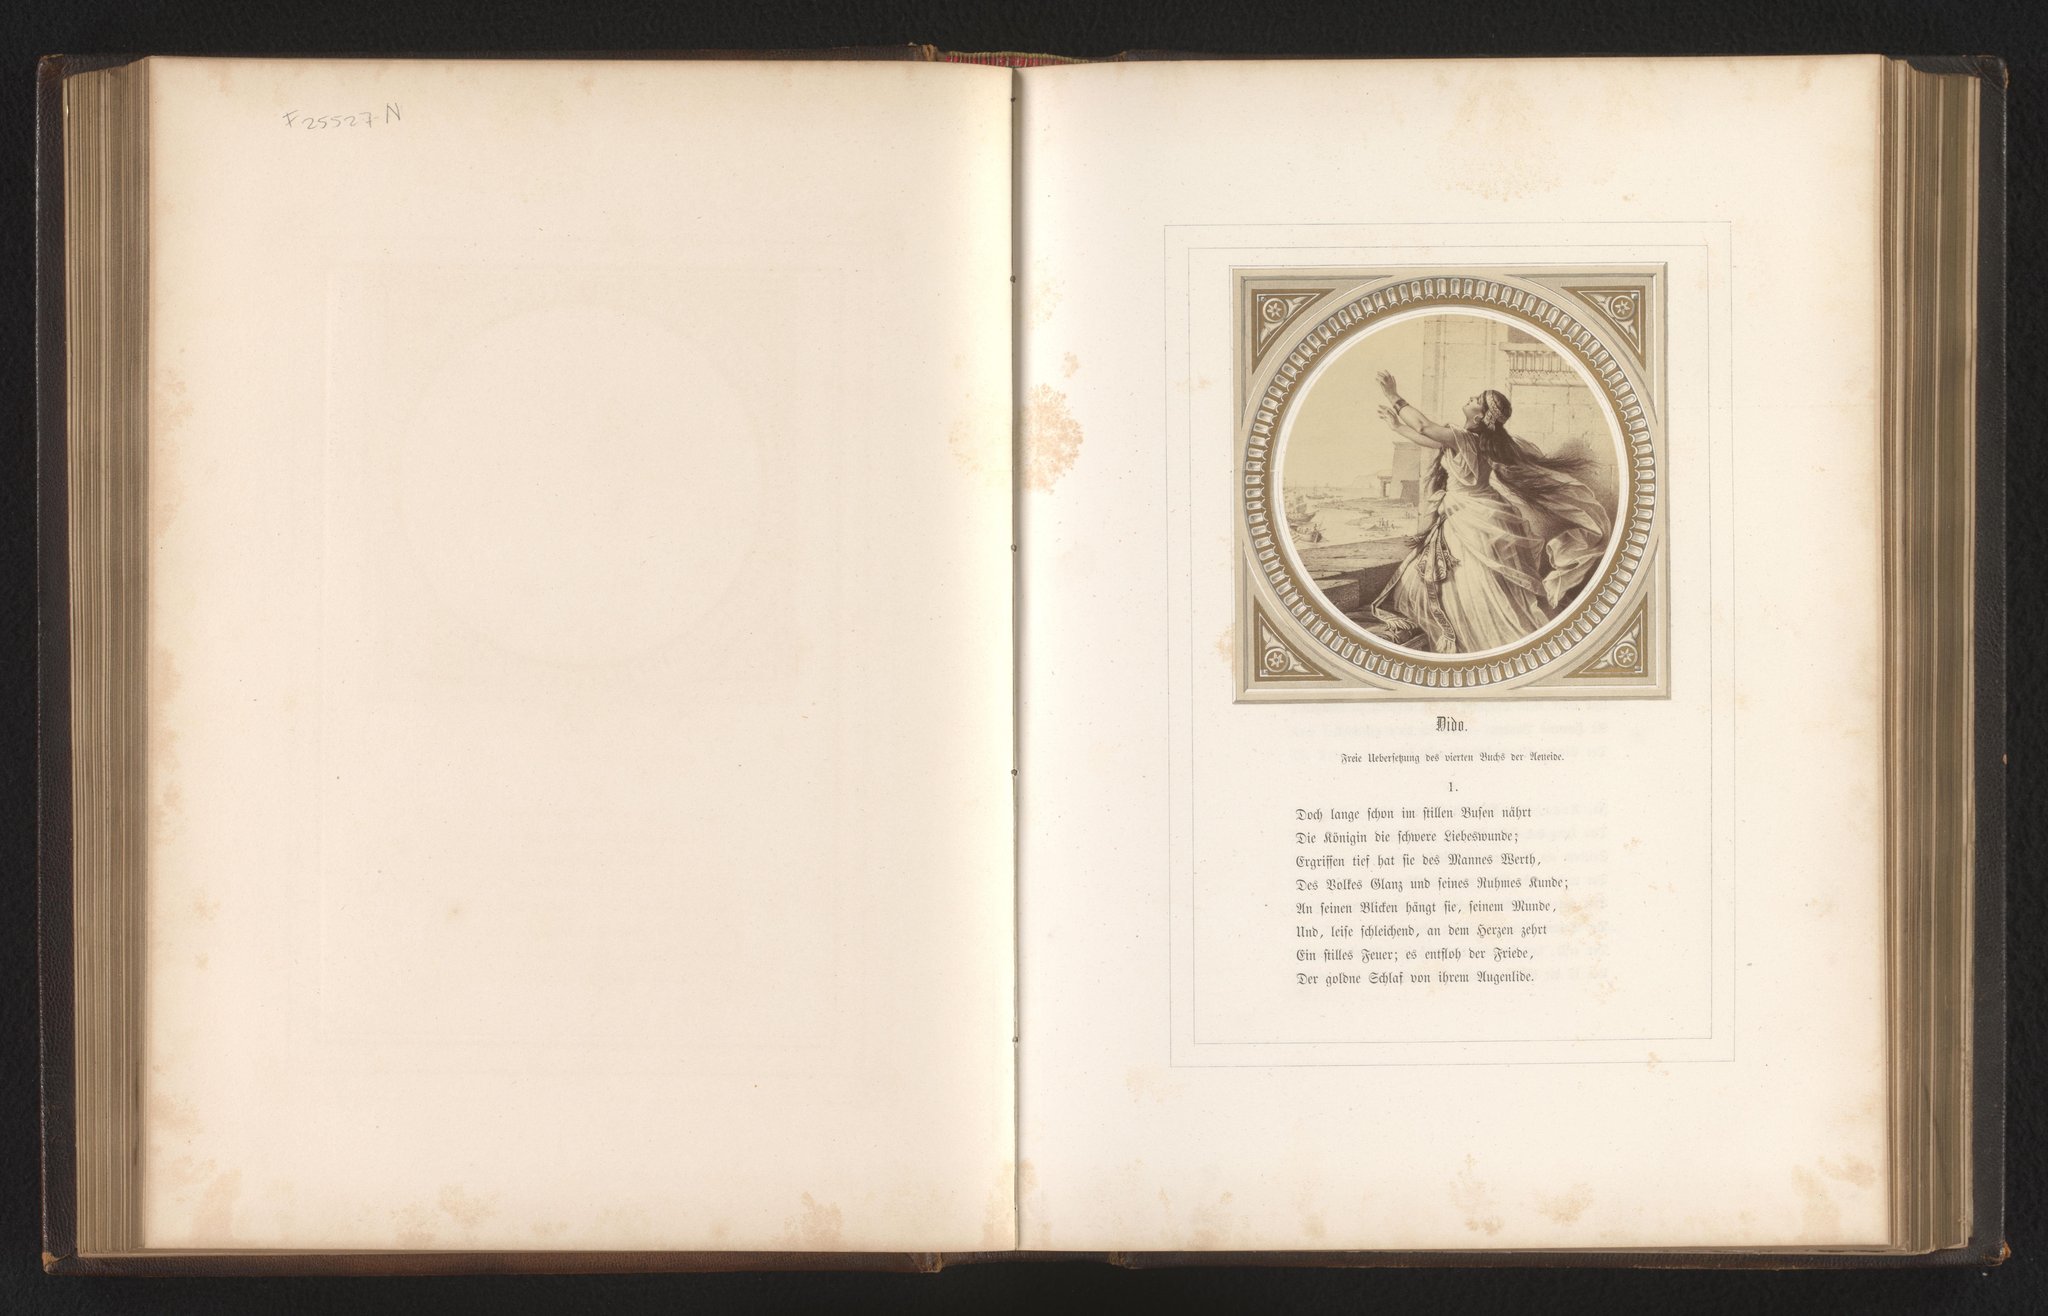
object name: photograph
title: Fotoreproductie van een tekening van Dido die Aeneas ziet wegvaren door Arthur von Ramberg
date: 1855-1862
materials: paper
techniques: albumen print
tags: the trojans' departure from carthage